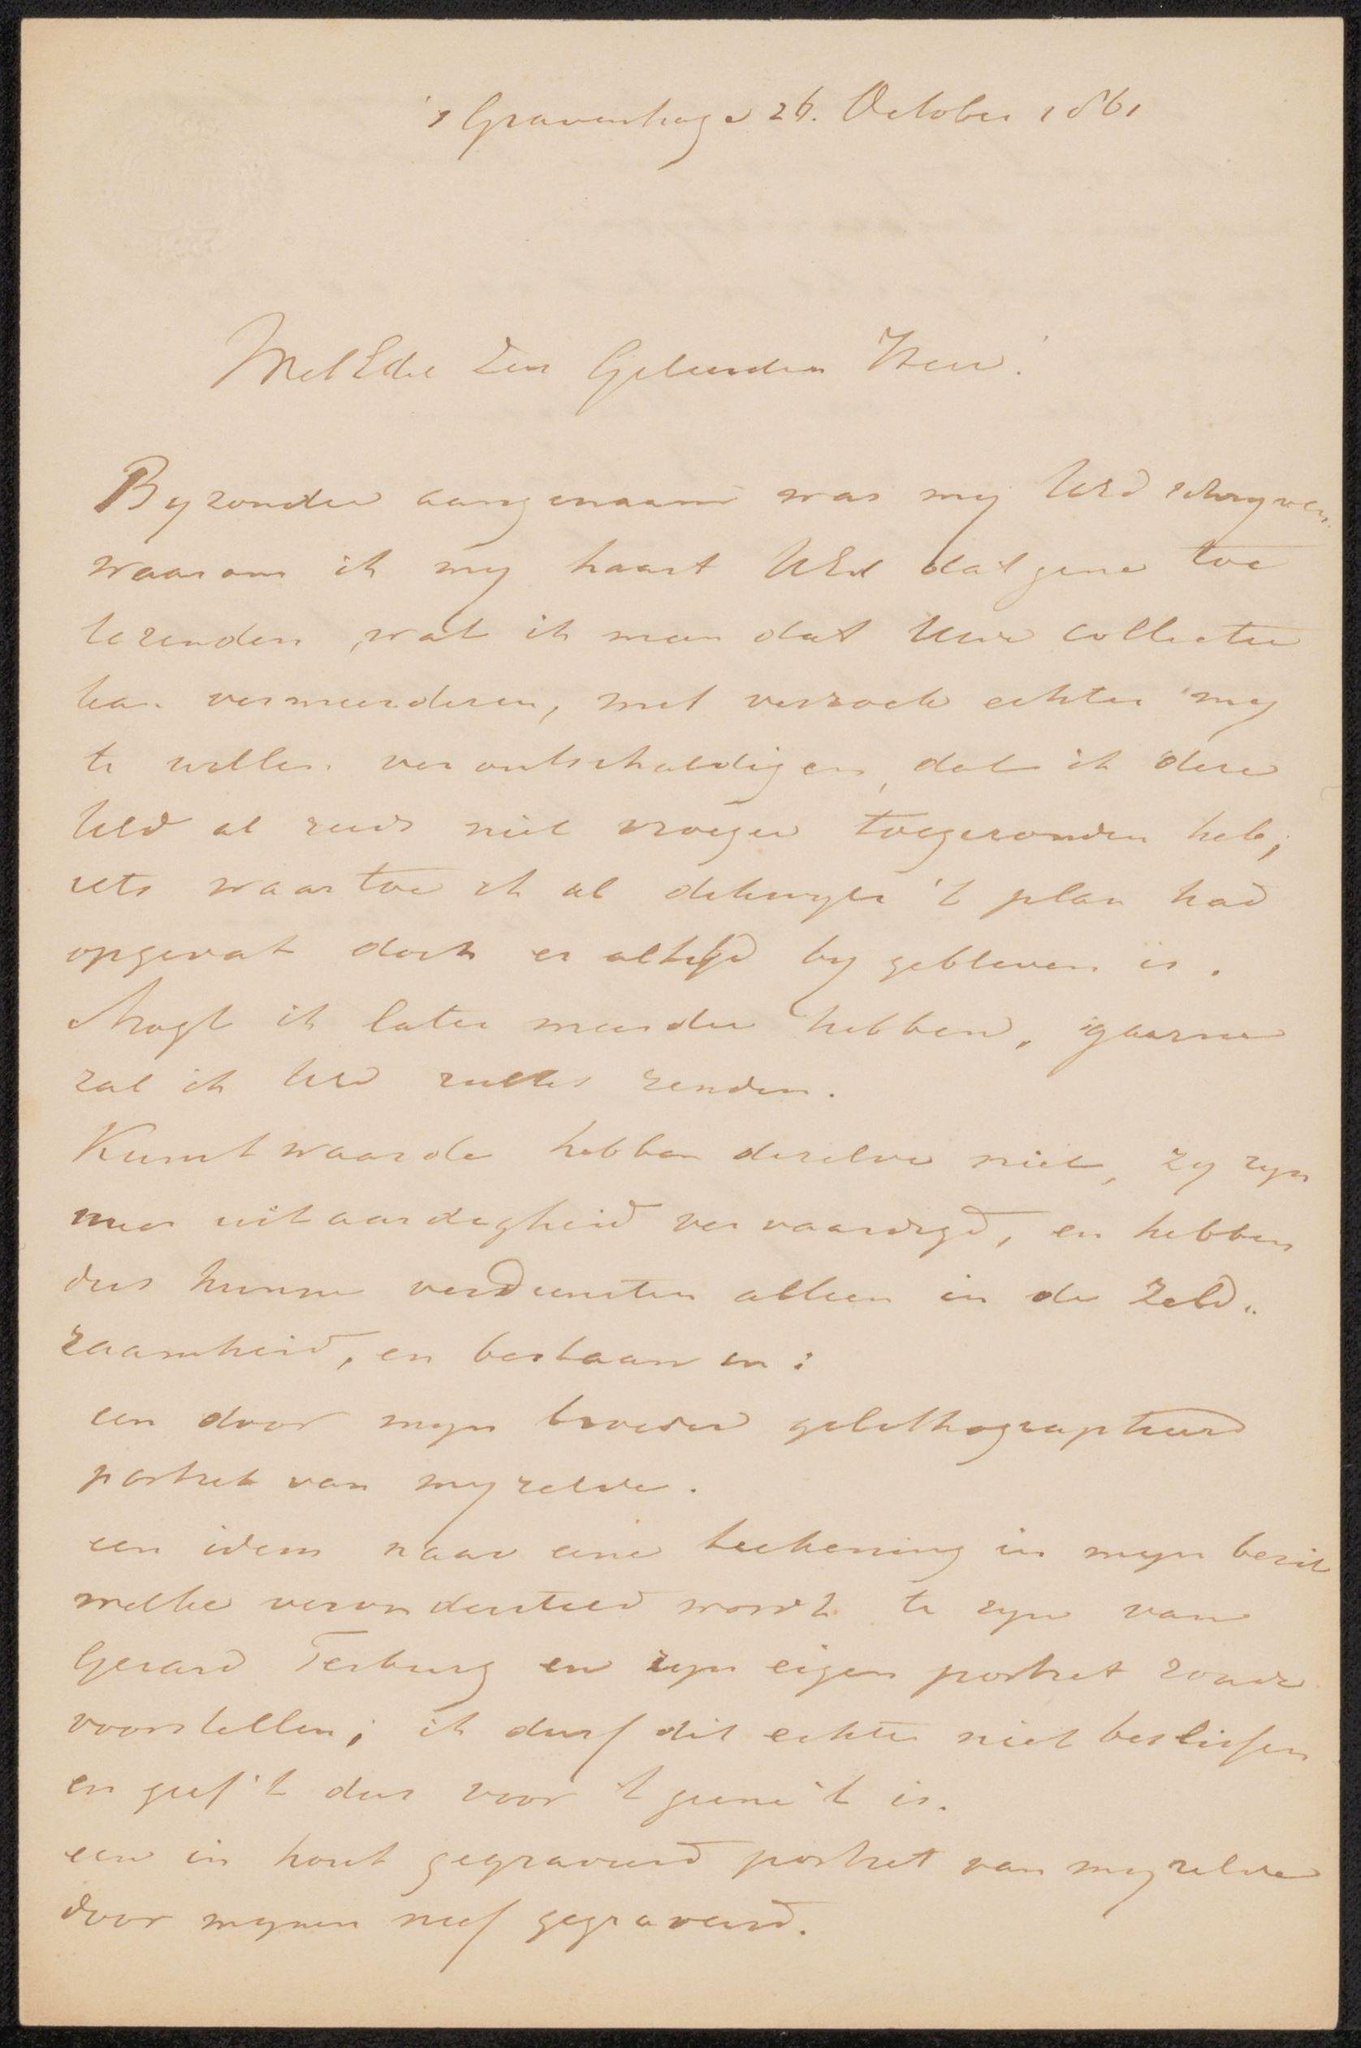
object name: letter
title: Brief aan Adriaan van der Willigen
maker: jan weissenbruch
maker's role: painter, print maker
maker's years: 1822-1880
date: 1861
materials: ink, paper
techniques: pen, writing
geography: the hague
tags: the hague, print maker, draughtsman, frederik hendrik weissenbruch, rotterdam, haarlem, adriaan van der willigen, deventer, gerard ter borch (ii), den bosch, painter, joseph hartogensis, utrecht, amsterdam, reinier craeyvanger, drawing, photography, cinematography, the graphic arts, historical persons (portraits and scenes from the life)